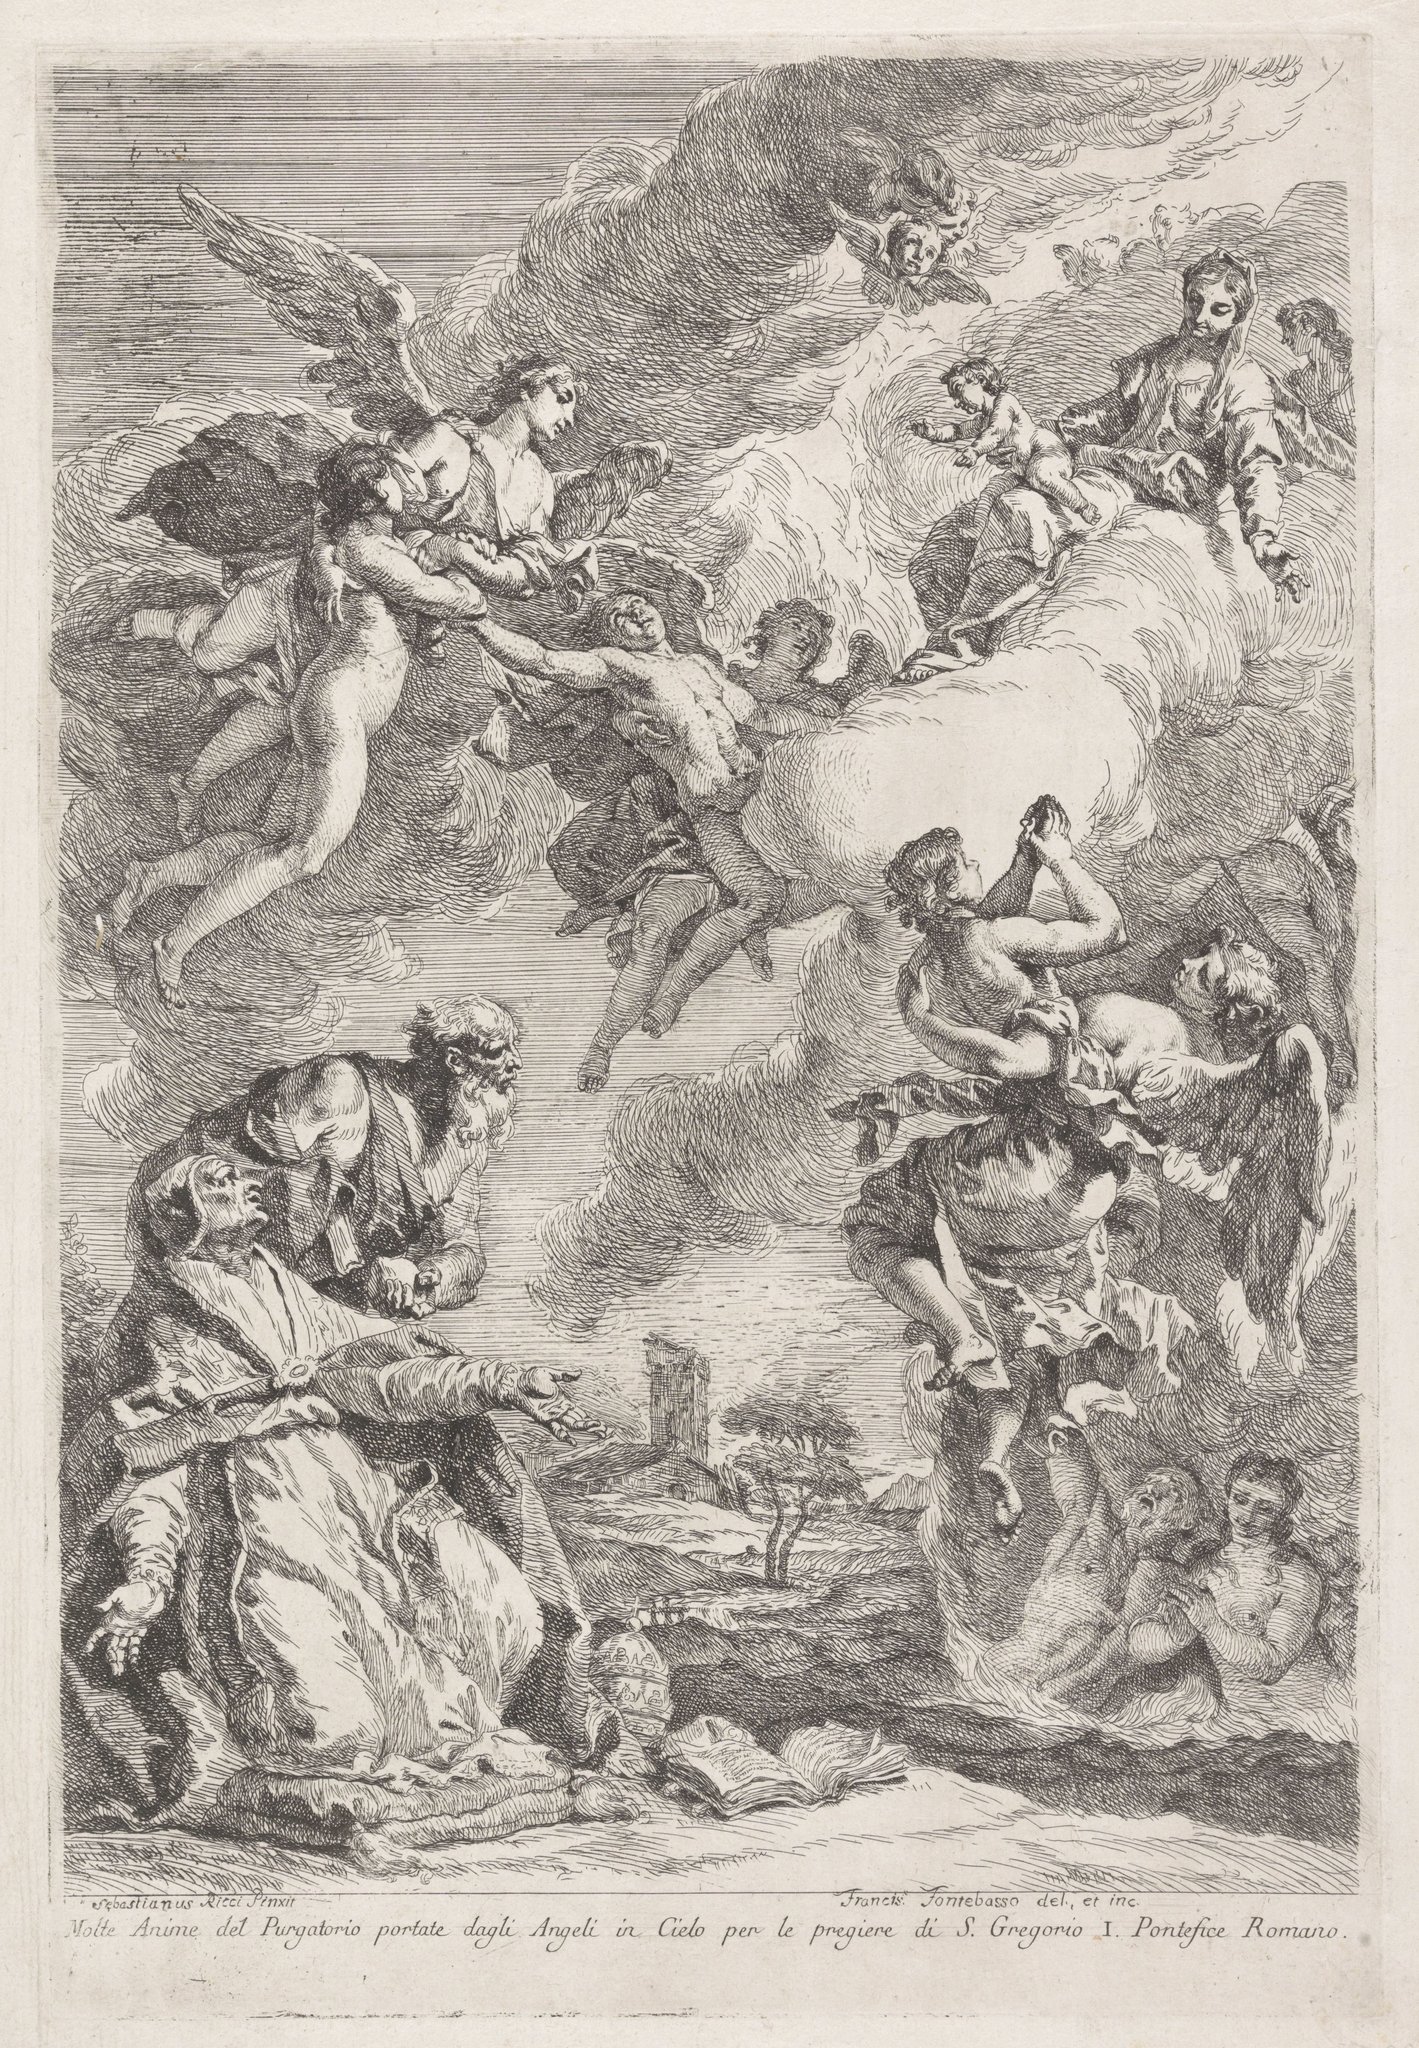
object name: print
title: De heilige Gregorius de Grote en de heilige Hieronymus bidden voor de zielen in het vagevuur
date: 1719-1768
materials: paper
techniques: etching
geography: italy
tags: liberation of the souls from purgatory, the monk and hermit jerome (hieronymus); possible attributes: book, cardinal's hat, crucifix, hour-glass, lion, skull, stone, pope gregory the great; possible attributes: dove, emperor trajan, angels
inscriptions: collector's mark: Lugt 240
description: De heilige Gregorius de Grote en de heilige Hieronymus bidden voor de zielen in het vagevuur. Engelen brengen de gestorvenen van het vagevuur naar de hemel. Rechtsboven Maria en het Christuskind op een wolk.